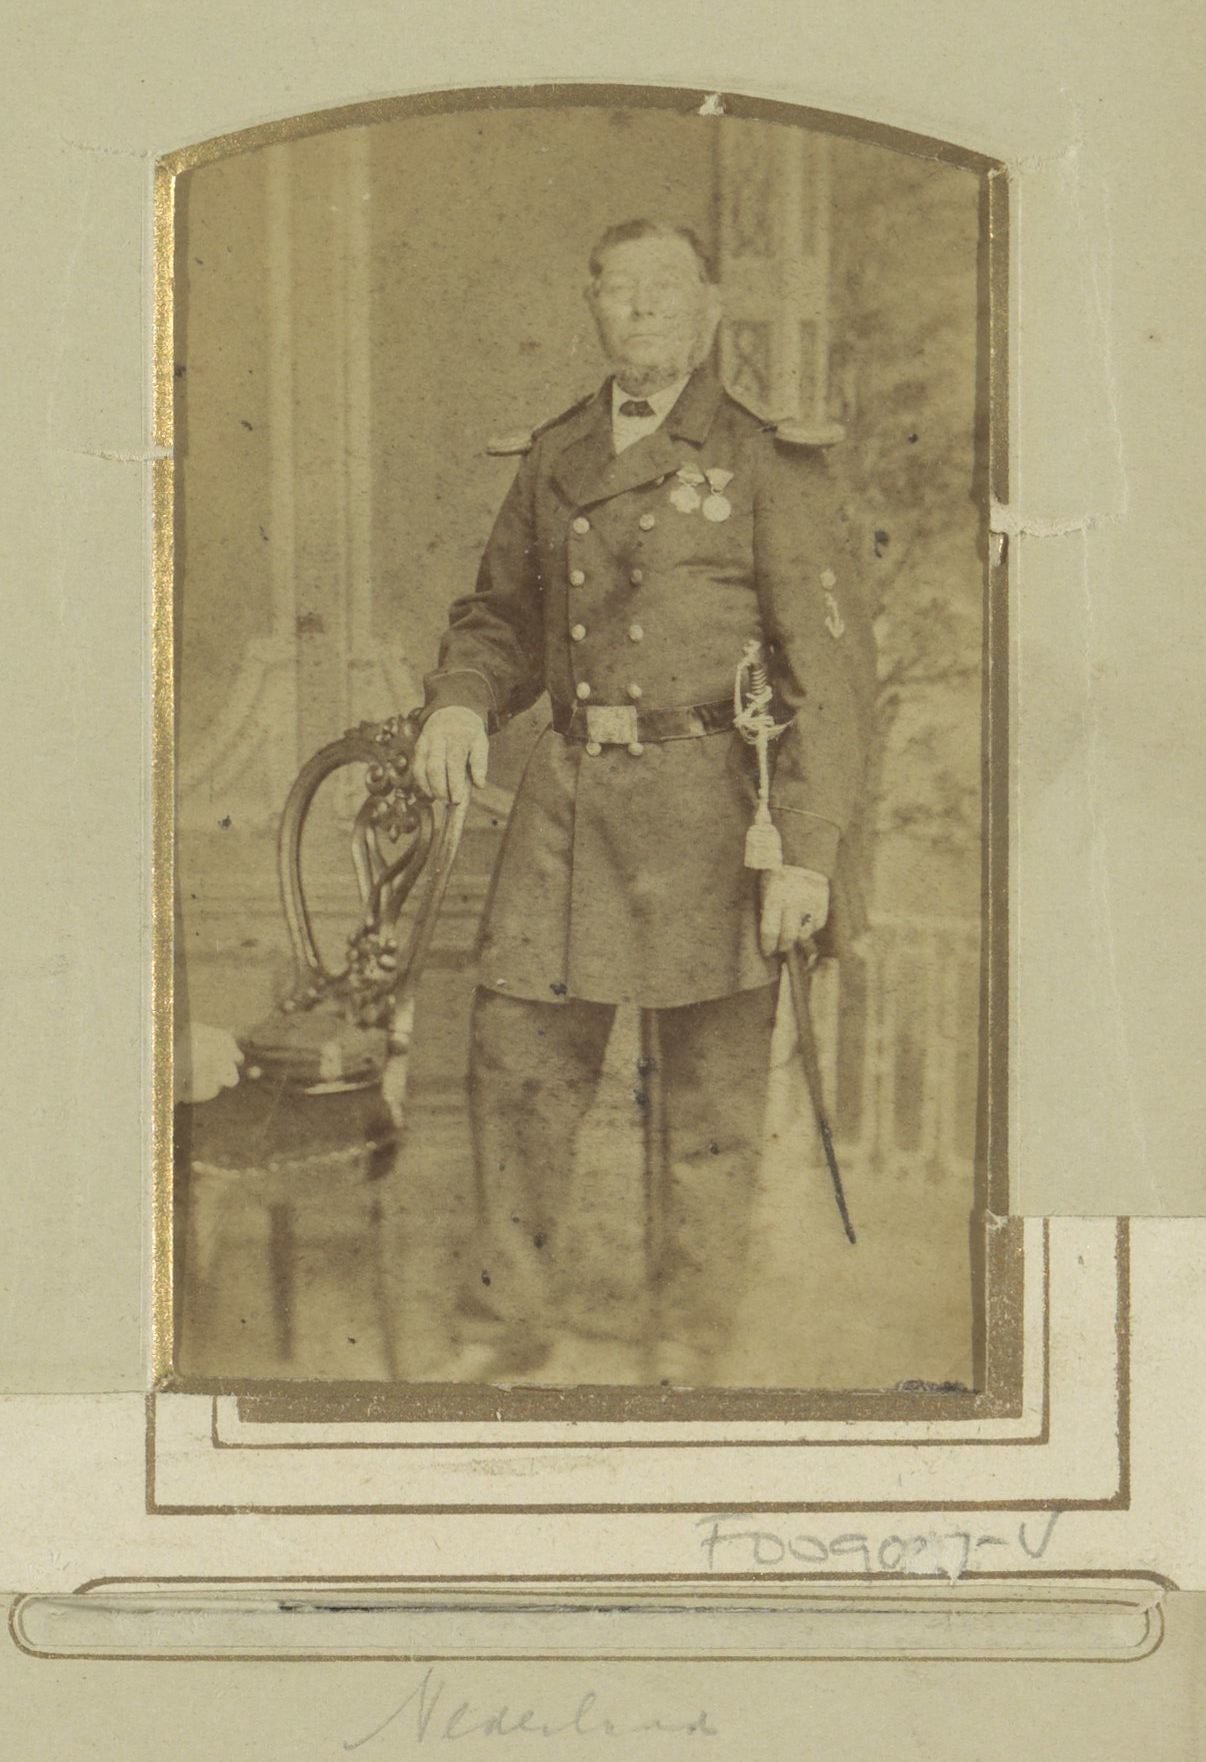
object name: photograph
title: Portret van een (vermoedelijk) Nederlandse militair, staand met sabel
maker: coenraad cornelis roskam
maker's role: fotograaf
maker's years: 1829-1892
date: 1870-1892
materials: cardboard, paper, photographic support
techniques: albumen print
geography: amsterdam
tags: studio requisites ~ photographer, hacking and thrusting weapons (with name), warfare; military affairs, (military) uniforms, division of armed forces, amsterdam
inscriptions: address: ‘[...]estraat tusschen de Keizersgracht en Kerkstr Z. 855 Amsterdam’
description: Onderdeel van Album met cartes-de-visite en kabinetfoto's van militairen in uniform.